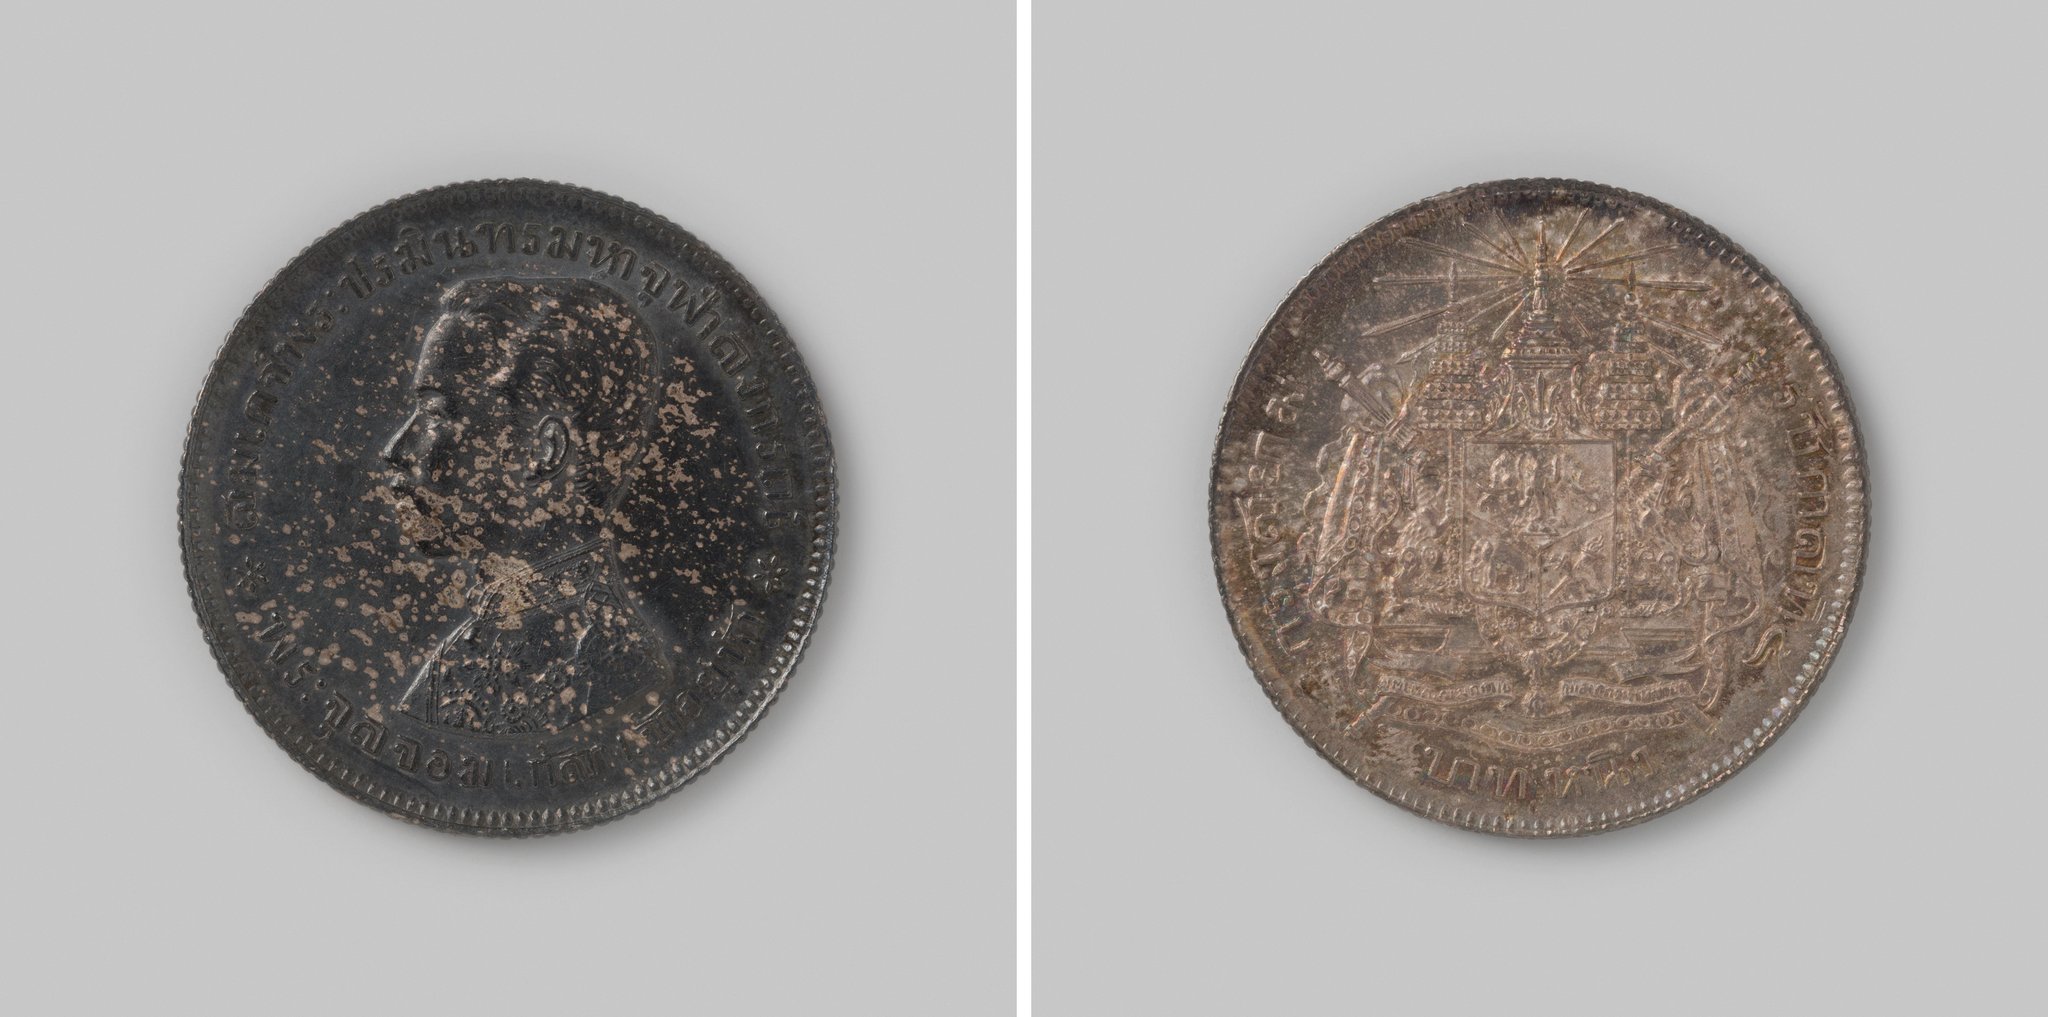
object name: coin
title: Thailand, baht, koning Chulalongkorn, 1868-1910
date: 1876-1901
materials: silver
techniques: striking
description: Zilveren munt. Voorzijde: borstbeeld van de koning naar links. Keerzijde: mantel, waarop twee gekruiste staven. Daarop door twee schildhouders gehouden door ridderorde omhangen wapenschild, ter weerszijden waarvan twee uitvouwbare schermen. Waarde-aanduiding in het Thais onderaan. Kartelrand.